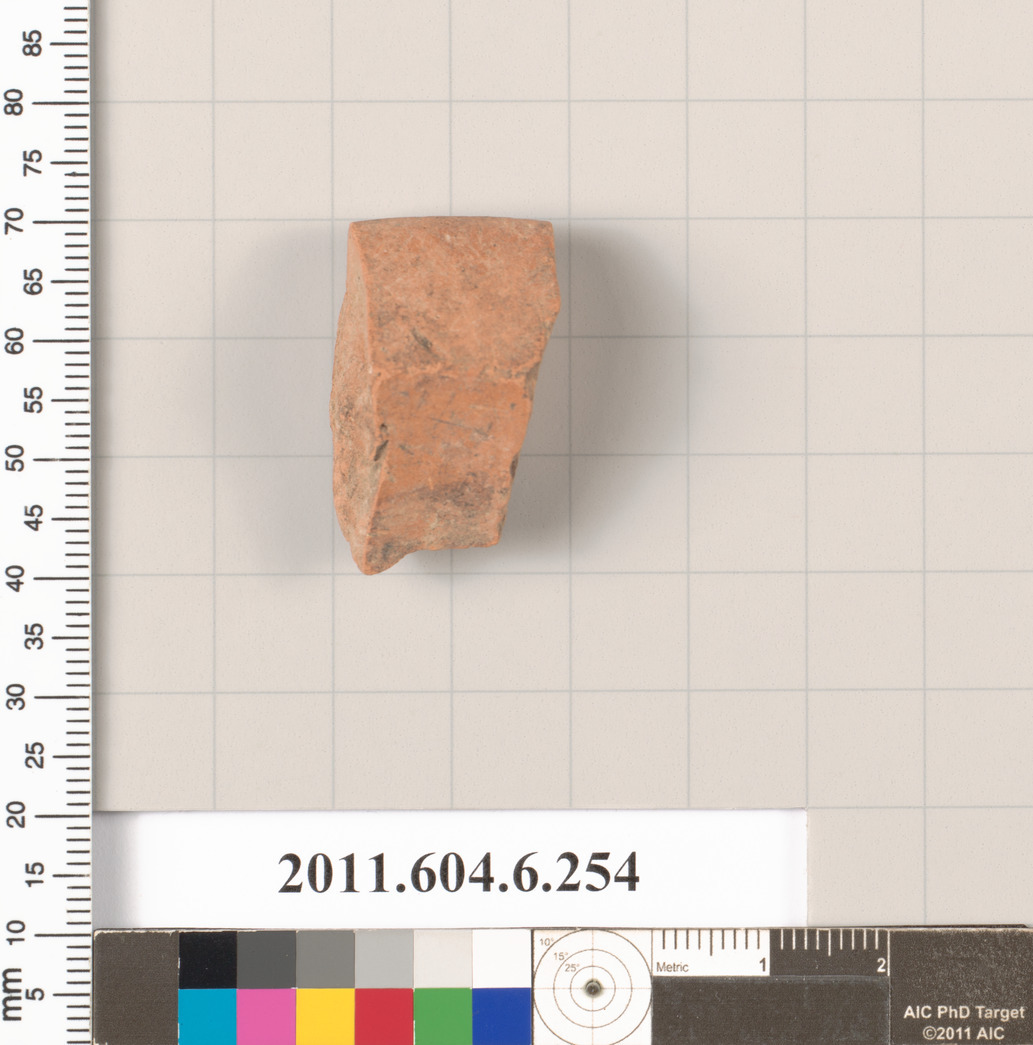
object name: undetermined shape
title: Terracotta fragment of an undetermined shape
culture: greek, attic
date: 600-401 BCE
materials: terracotta